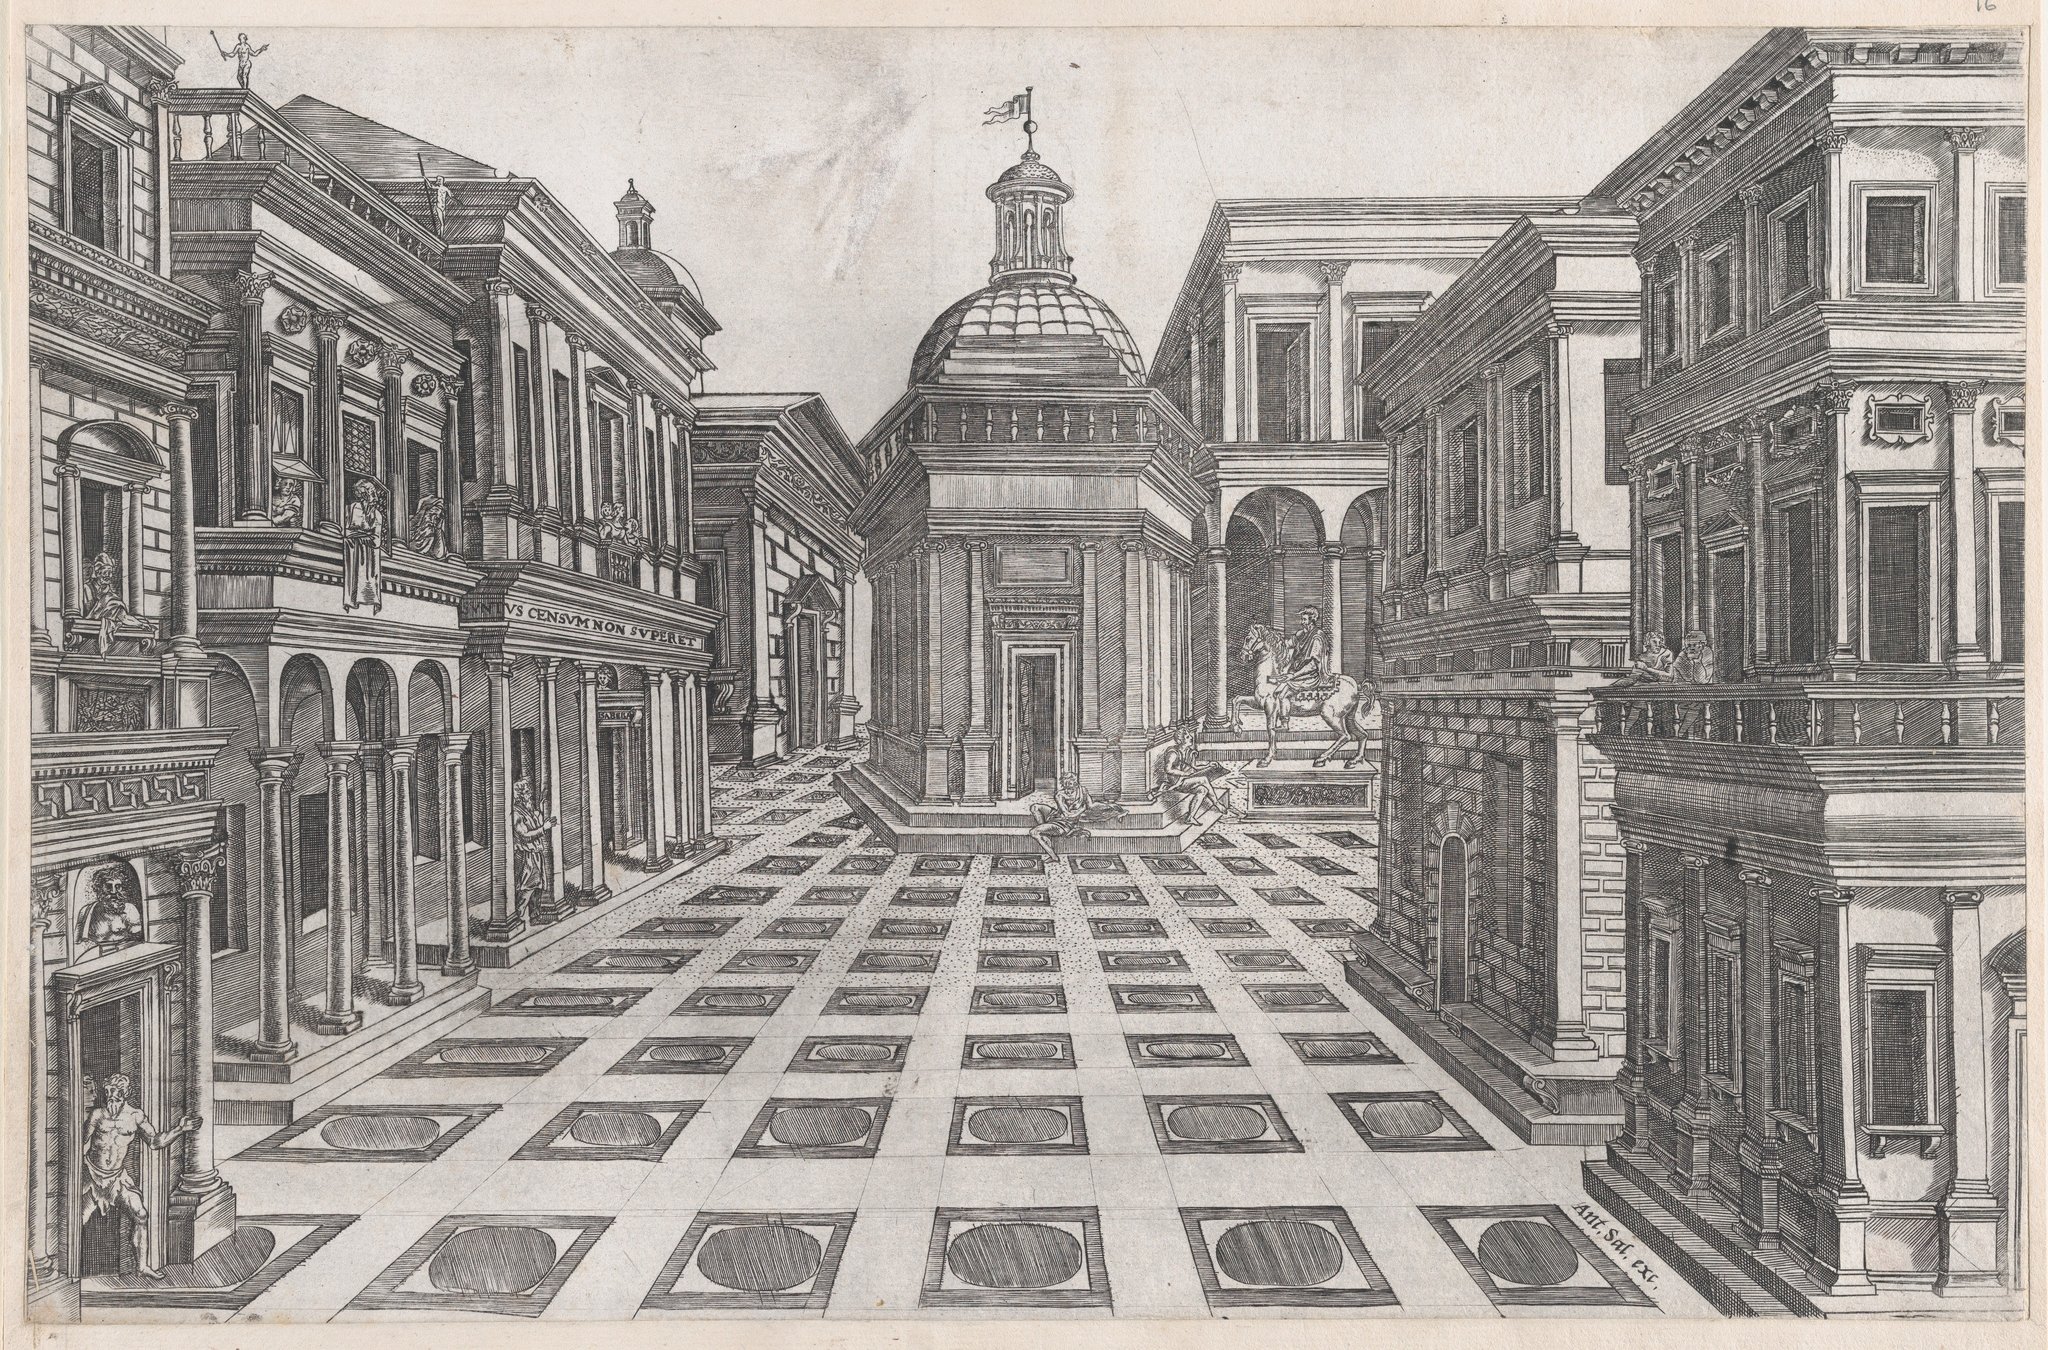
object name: print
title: View of Buildings Adjoining the Capitol, from "Speculum Romanae Magnificentiae"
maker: Anonymous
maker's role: artist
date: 1501-1600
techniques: engraving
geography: rome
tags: human figures,buildings,rome